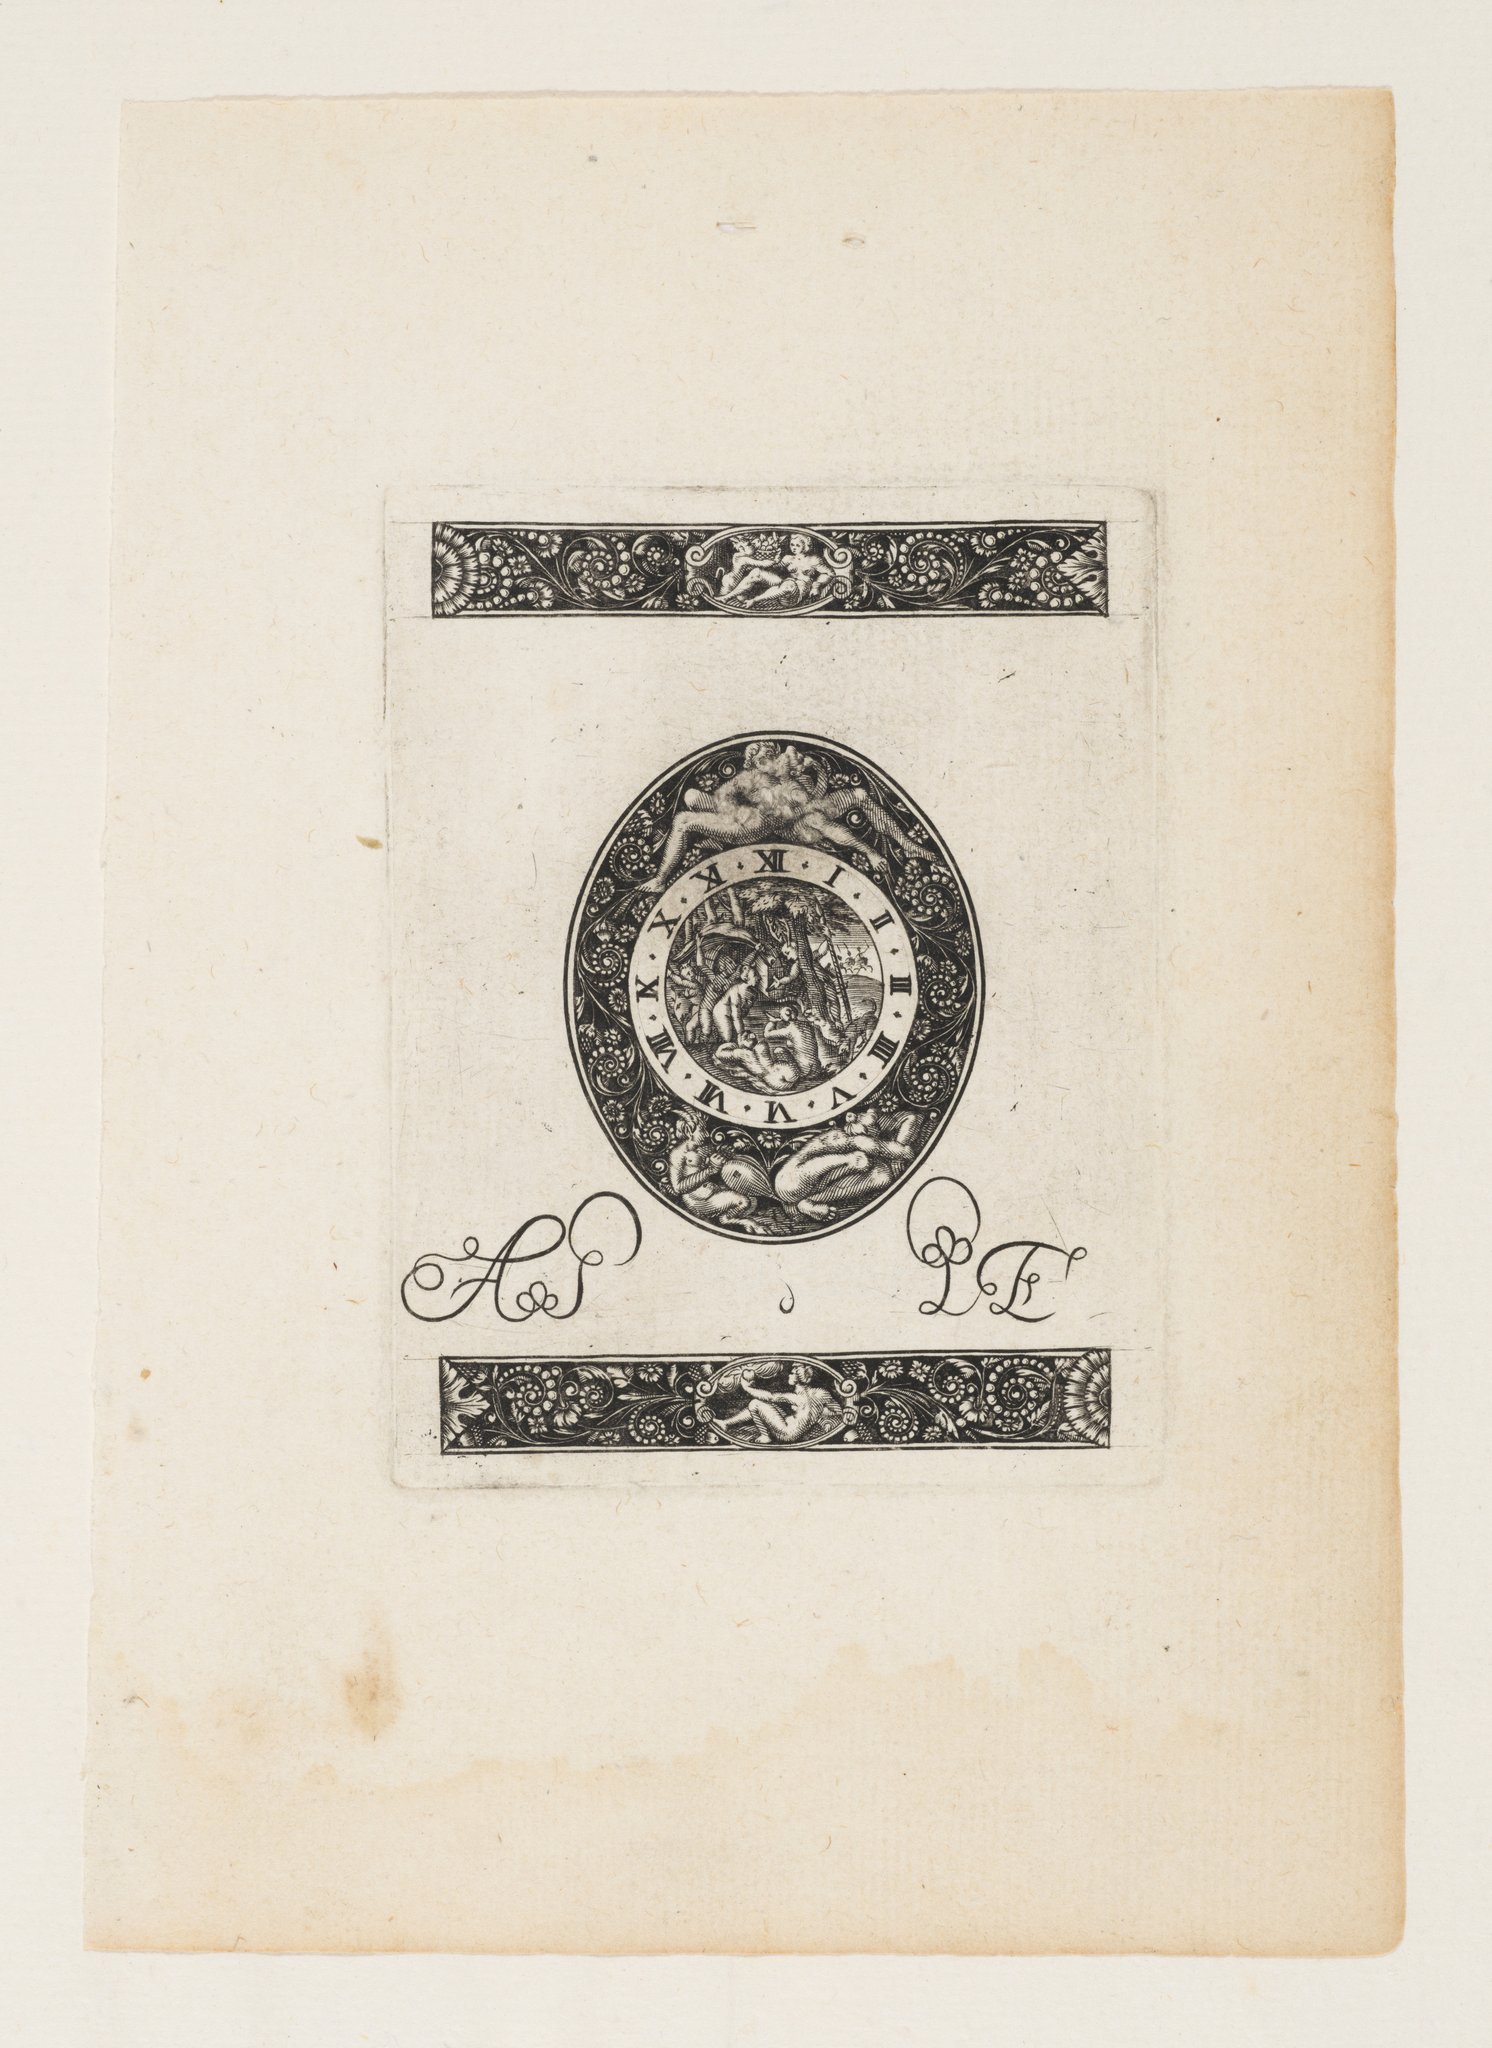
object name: ornament architectue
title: Oval Watch Plate with Diana and Actaeon, form a Series of Six Designs for Watch Cases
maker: antoine jacquard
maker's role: artist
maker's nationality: french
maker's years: 1610-1630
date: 1610-1615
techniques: embroidery, engraving